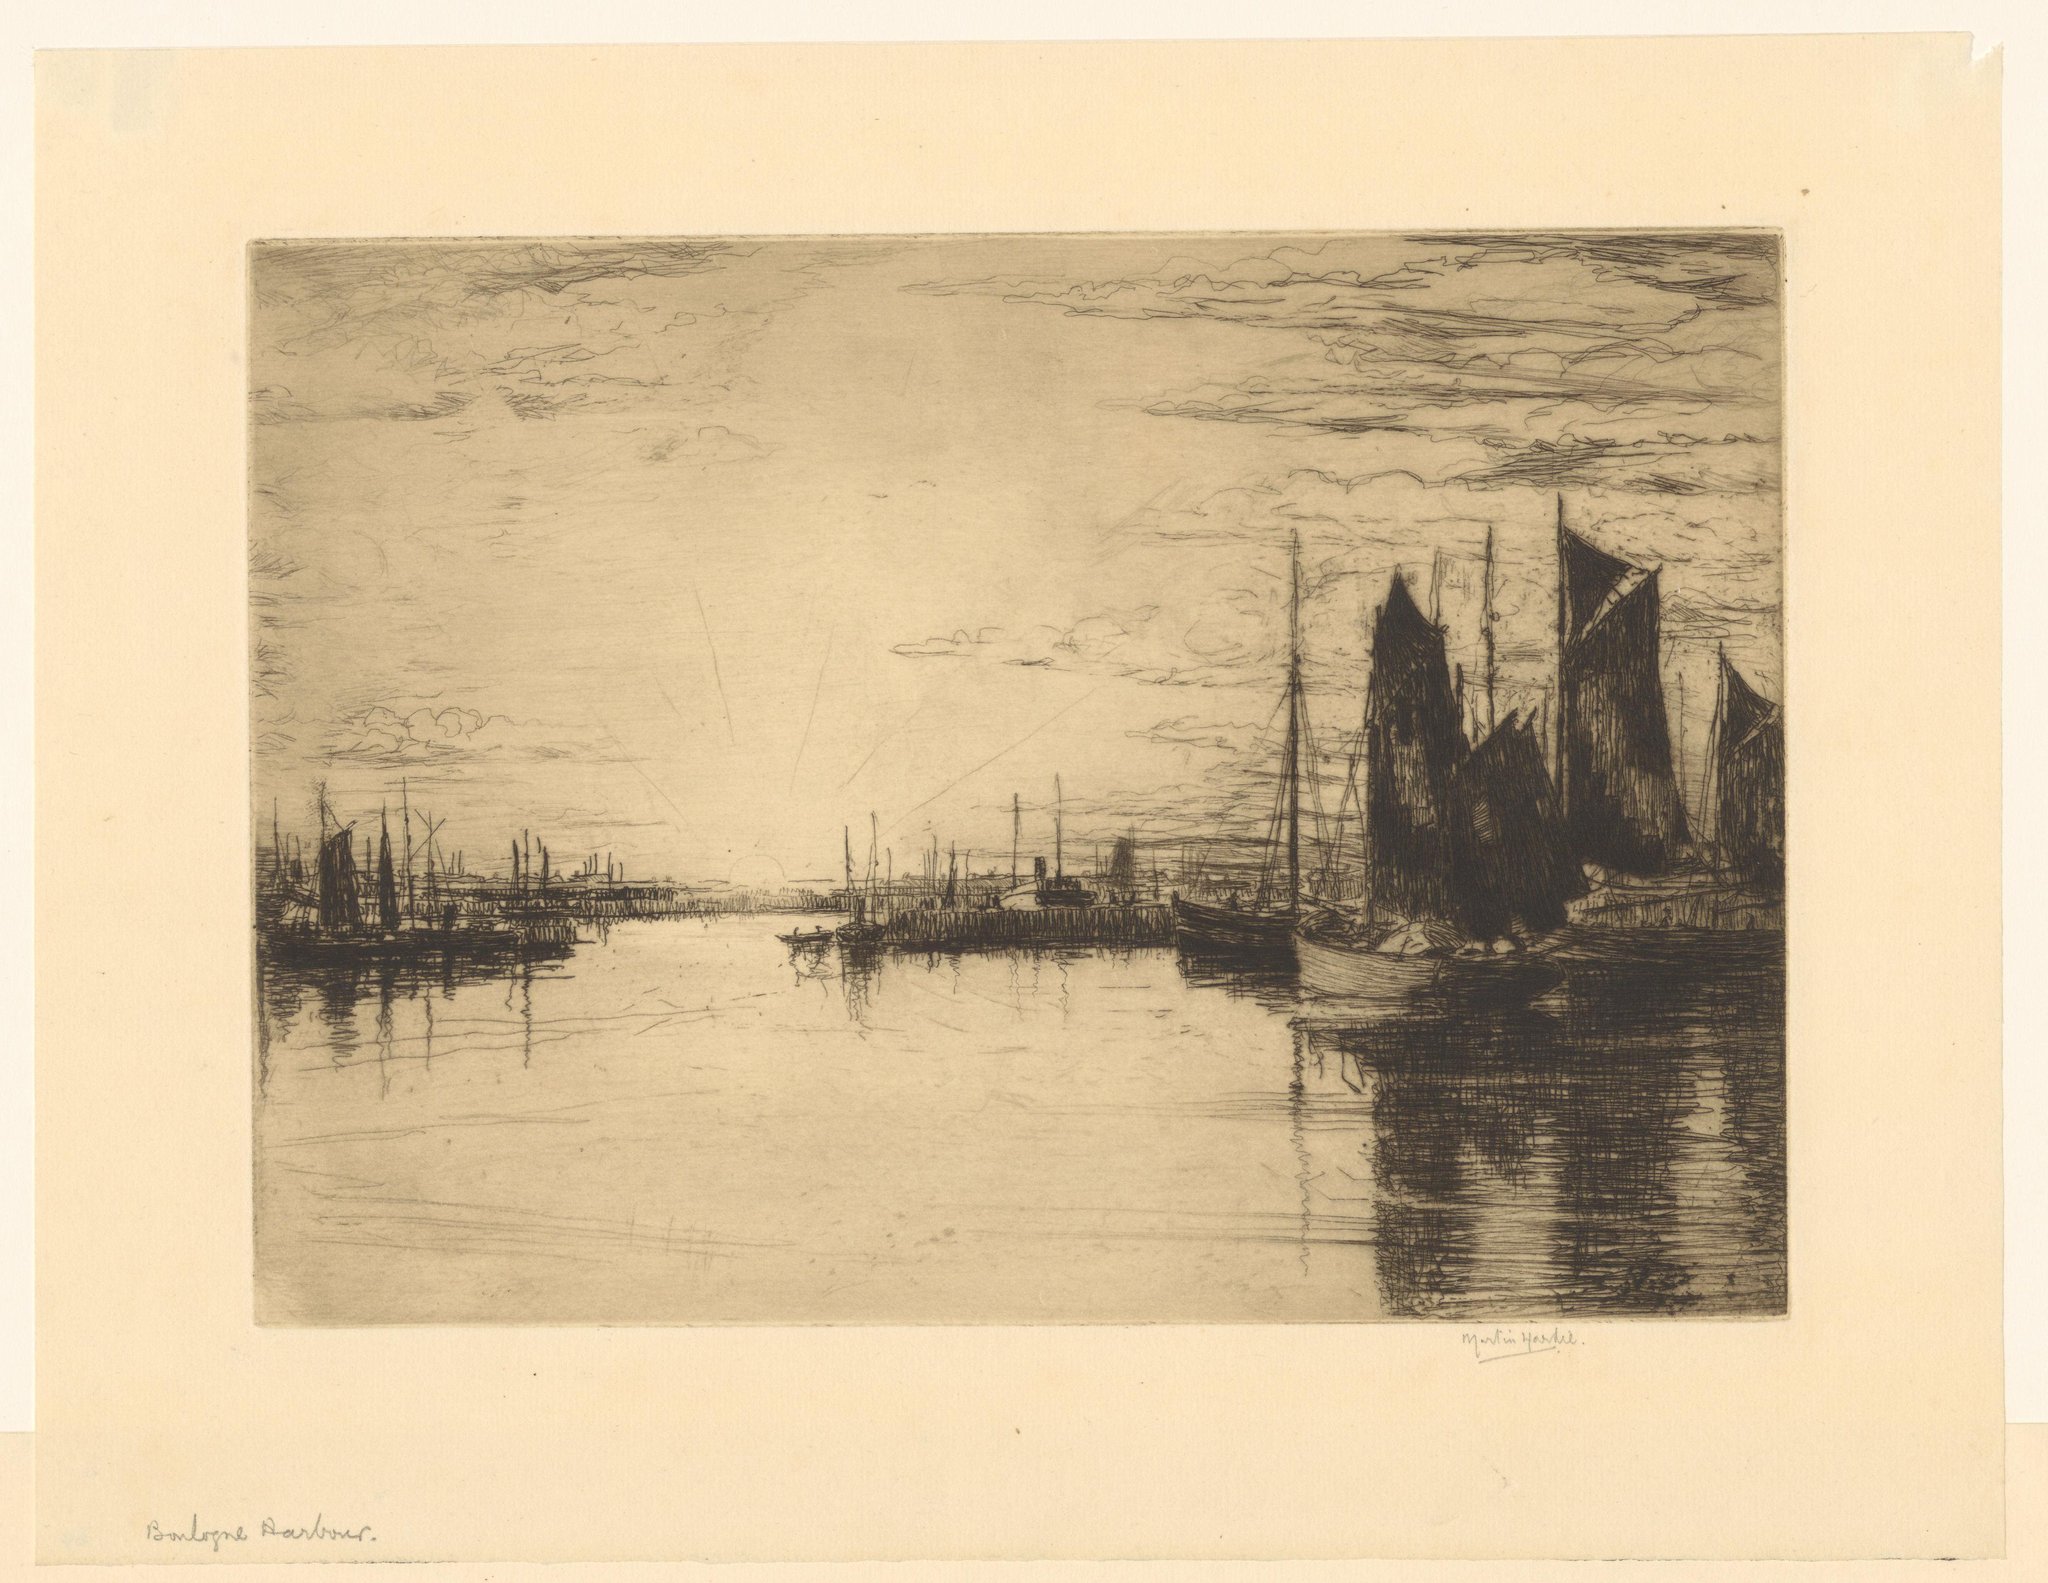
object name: print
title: Haven van Boulogne-sur-Mer bij zonsondergang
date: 1916-1918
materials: paper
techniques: etching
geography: boulogne-sur-mer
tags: harbour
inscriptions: collector's mark: Lugt 2228, annotation: ‘Martin Hardie’, collector's mark: Lugt 2760